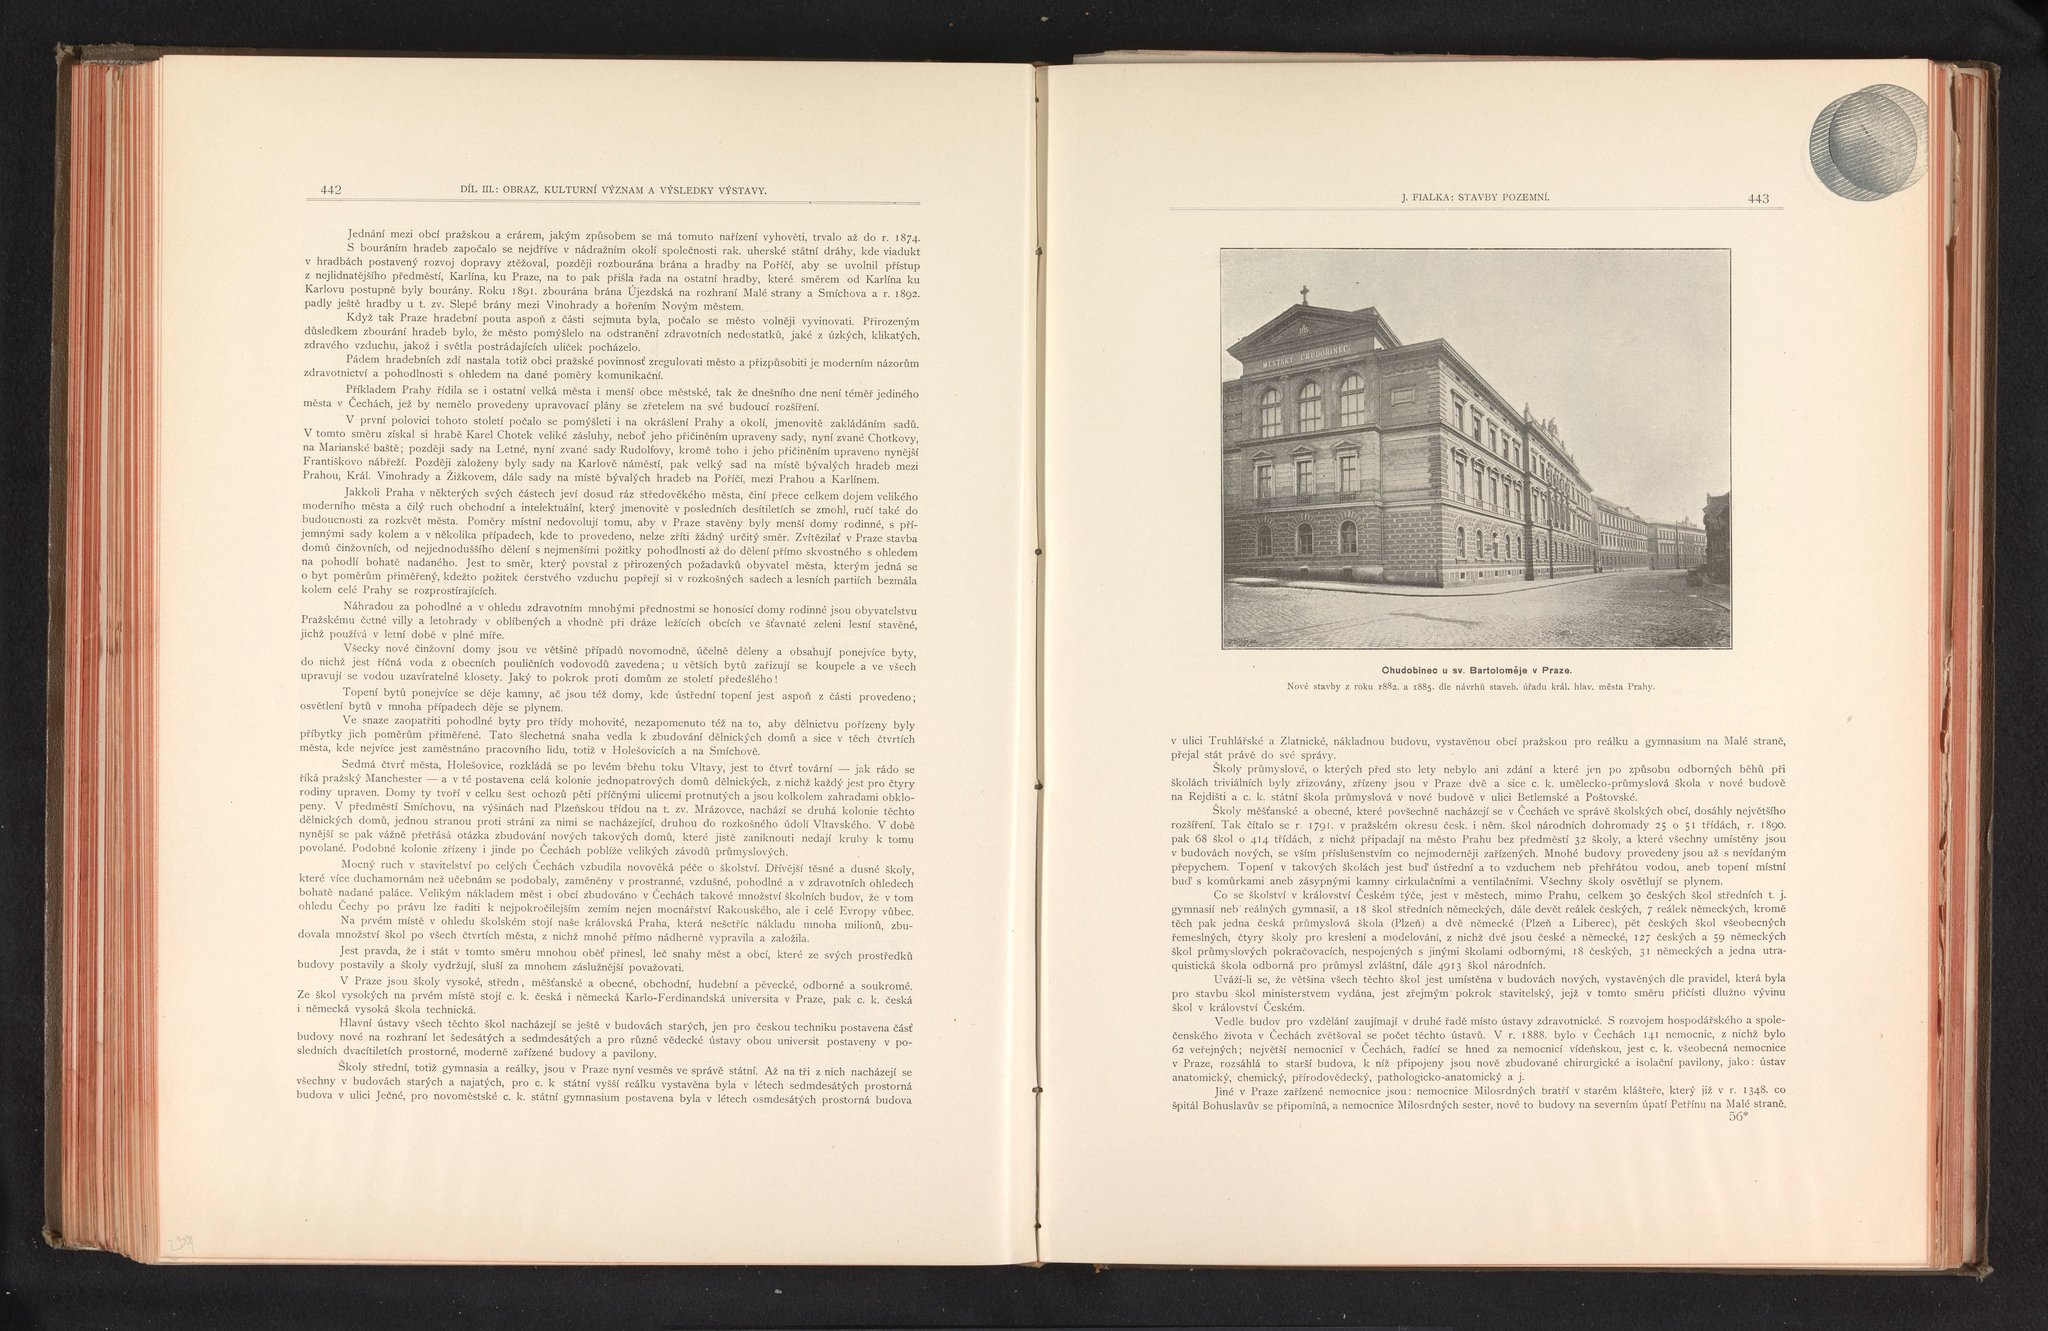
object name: page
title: Chudobinec u sv. Bartolomeje v Praze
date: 1891-1895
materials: paper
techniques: autotype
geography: prague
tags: façade (of house or building), workhouse, penal camp, penitentiary, chain gang